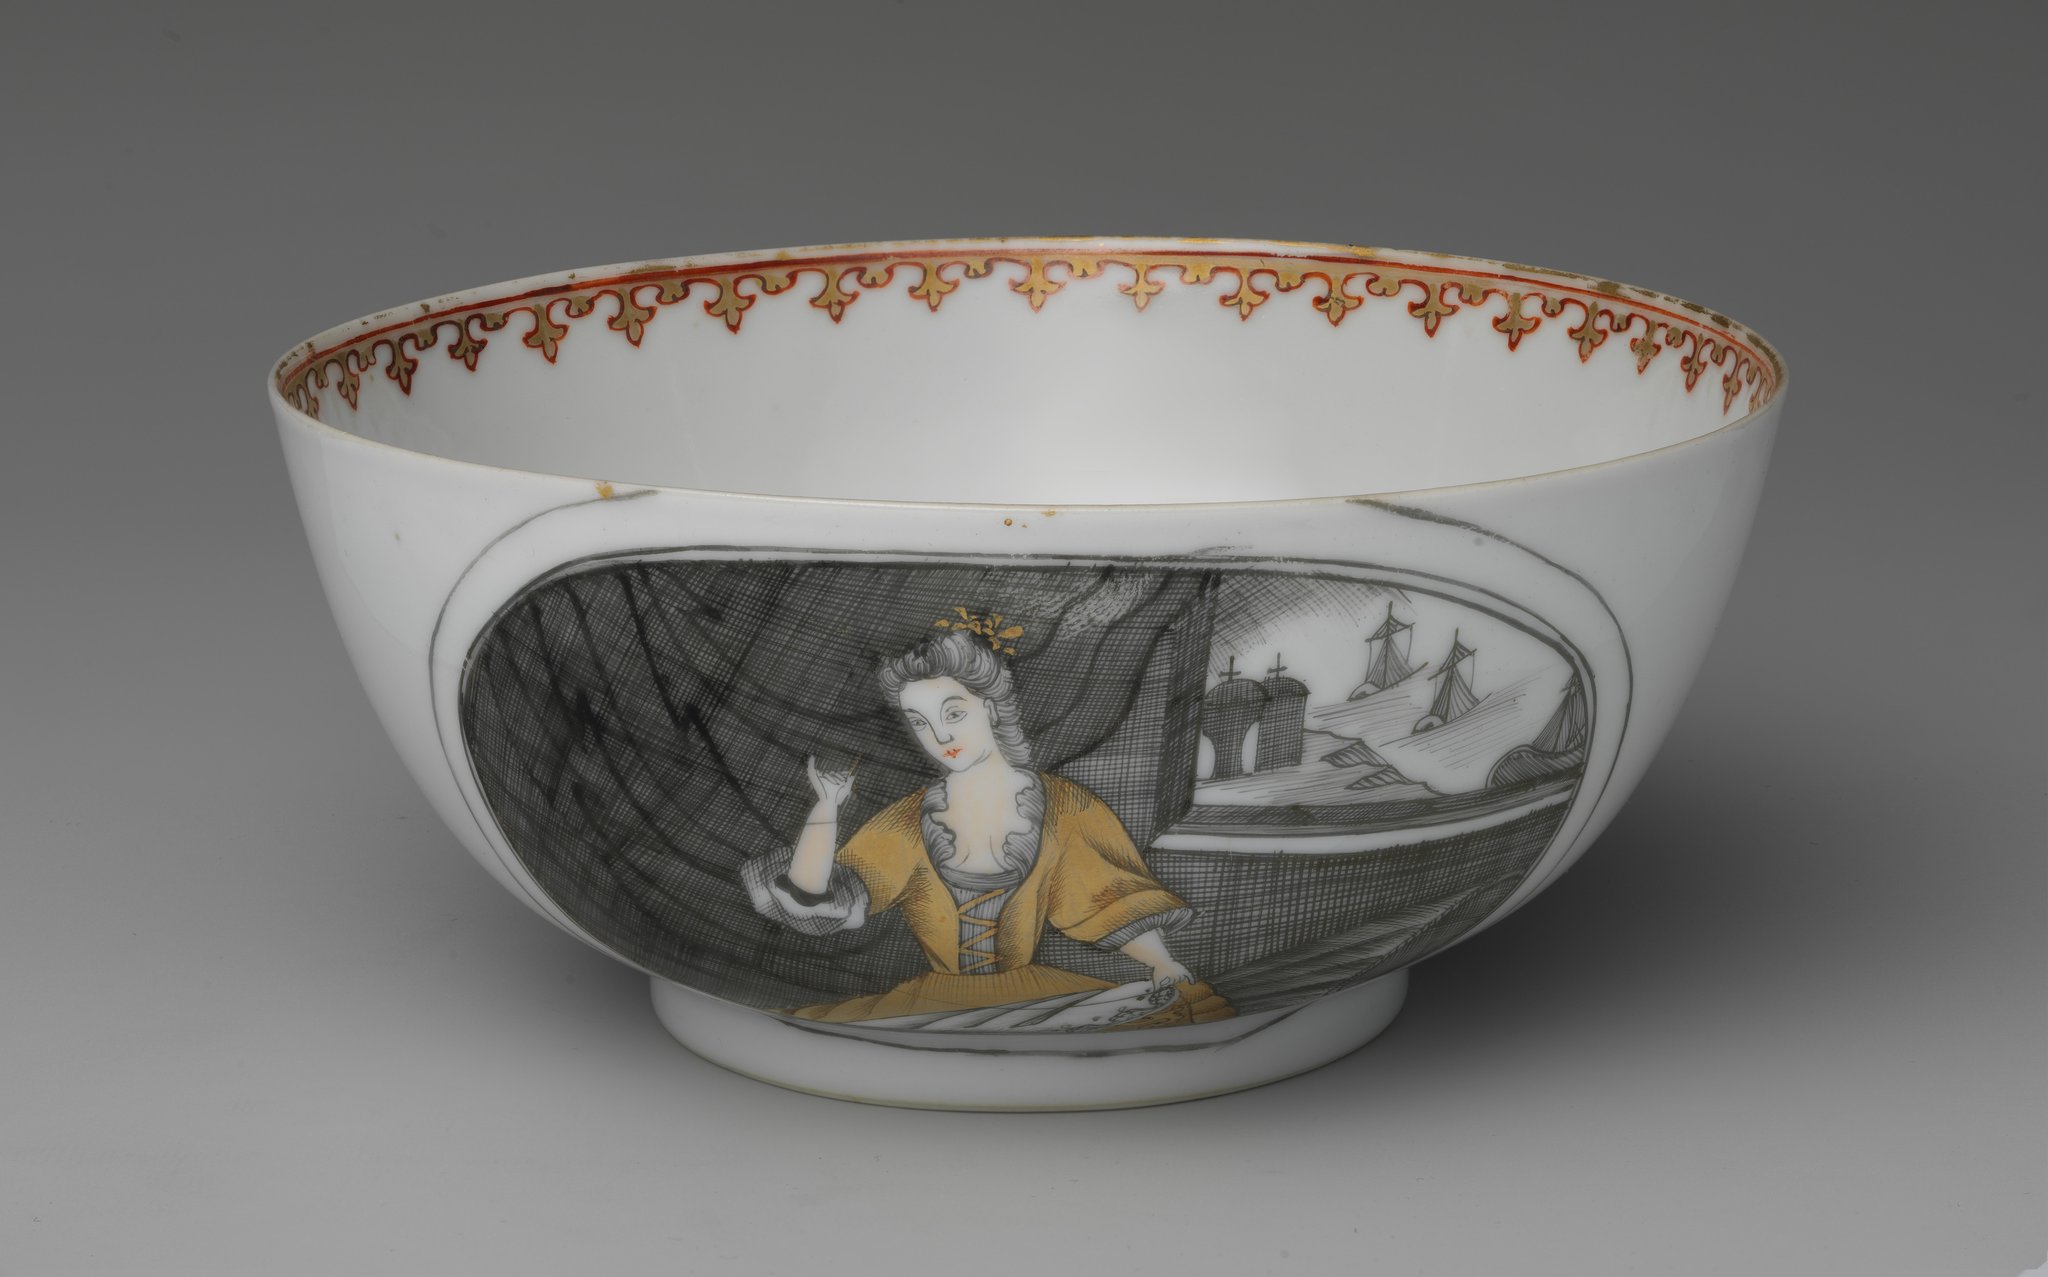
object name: bowl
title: Bowl (part of a service)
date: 1750-1770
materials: hard paste porcelain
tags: women,sewing